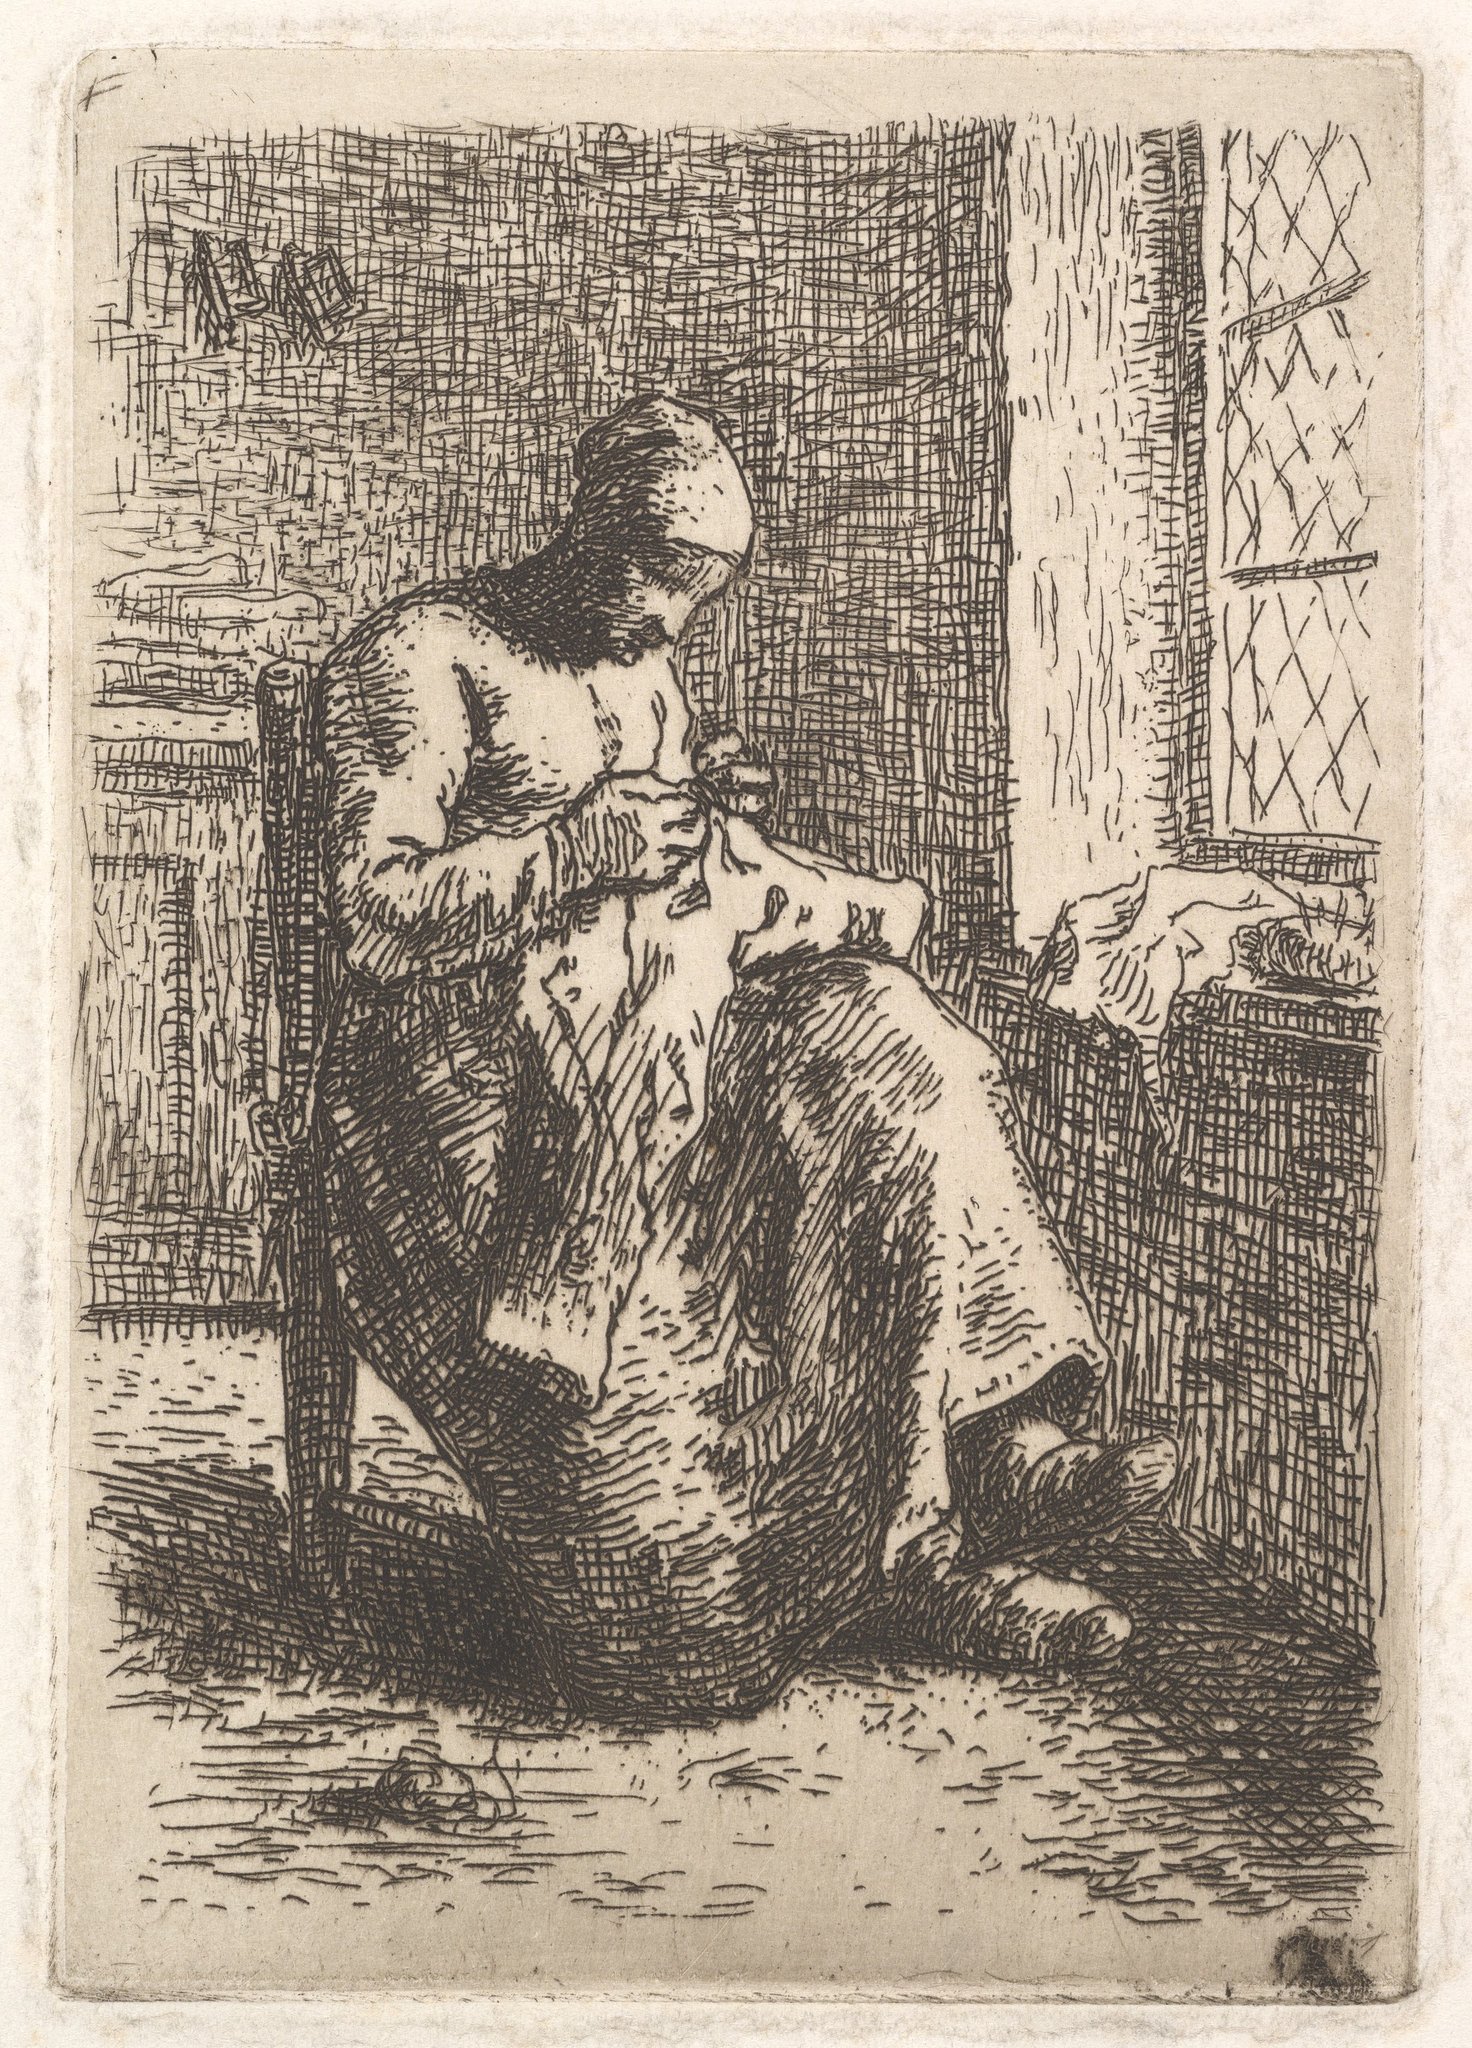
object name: print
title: The Seamstress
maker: jean-françois millet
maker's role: artist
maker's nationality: french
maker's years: 1814-1875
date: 1853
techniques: printmaking, etching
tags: women,working